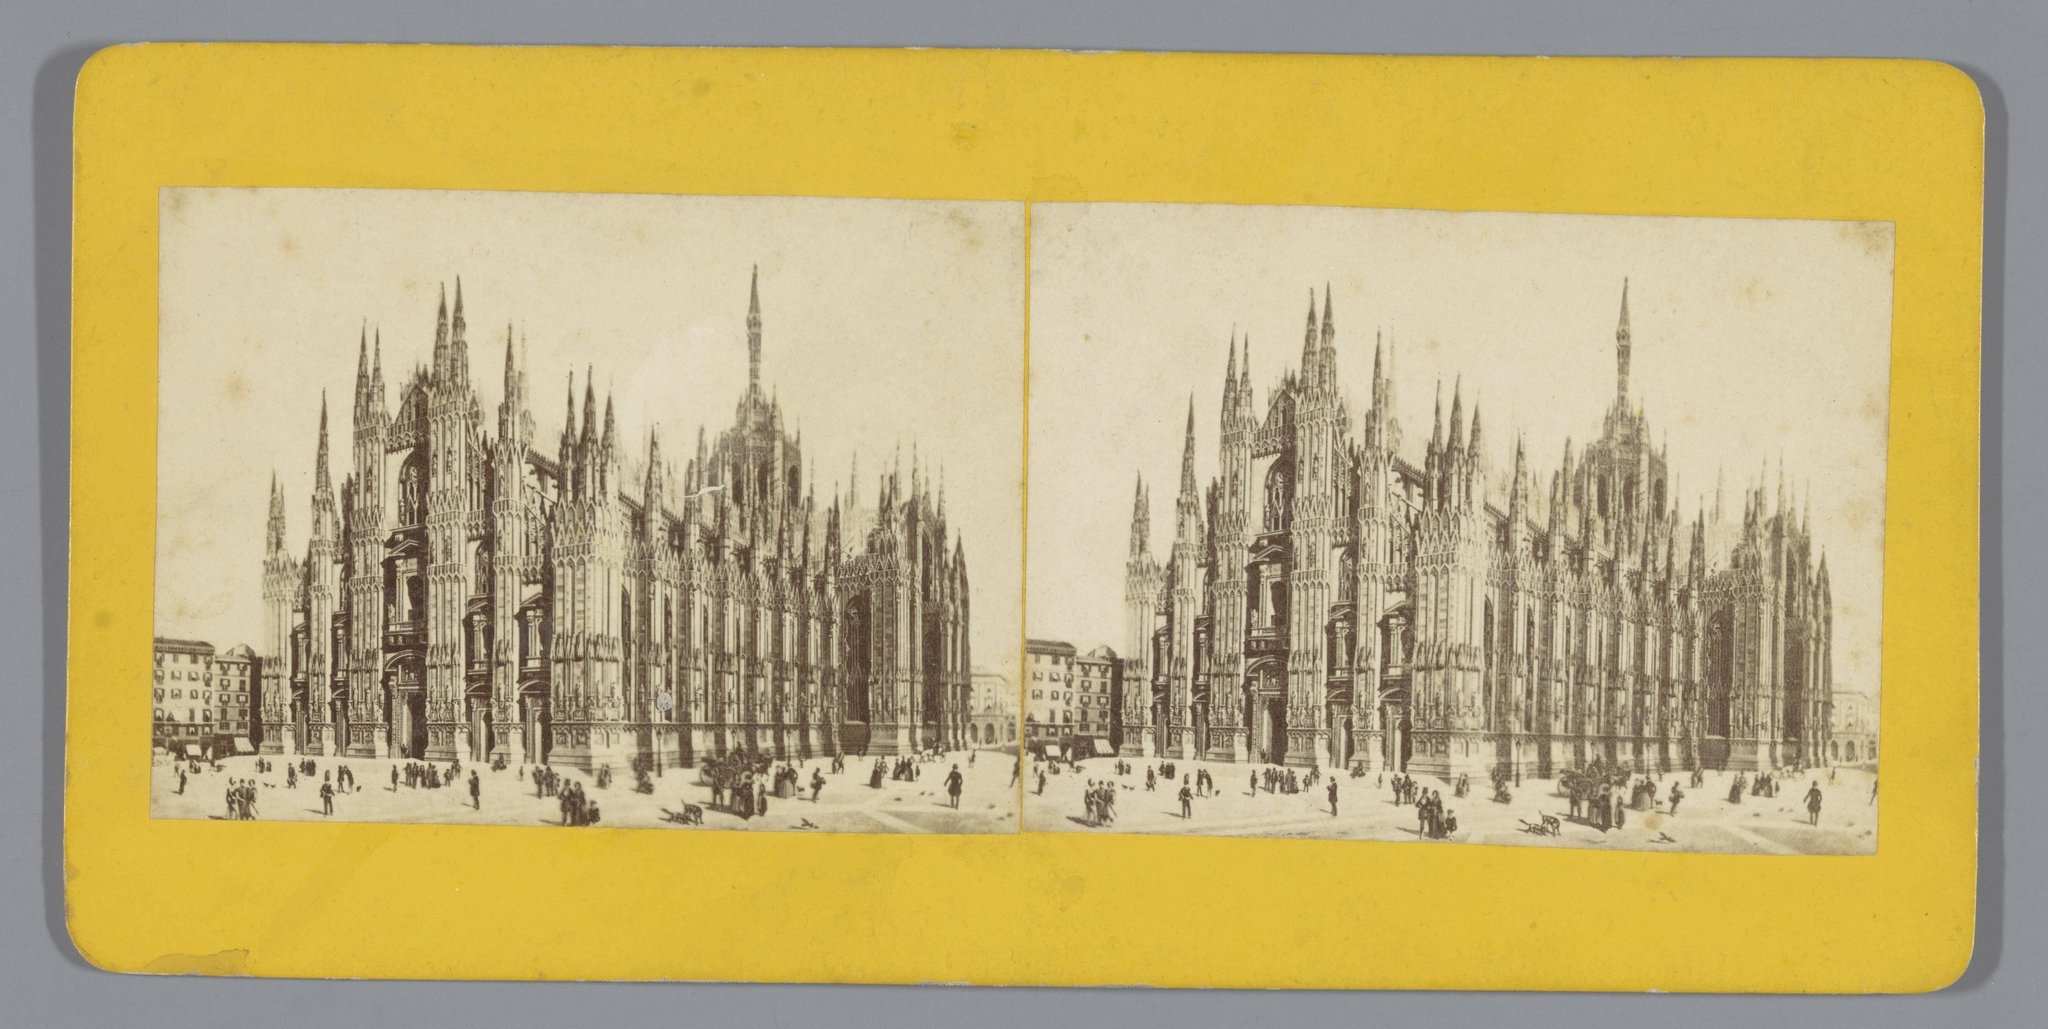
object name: stereograph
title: Exterieur van de Dom van Milaan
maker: Anonymous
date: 1850-1880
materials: cardboard, photographic support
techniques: albumen print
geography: milan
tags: church (exterior), façade (of house or building)